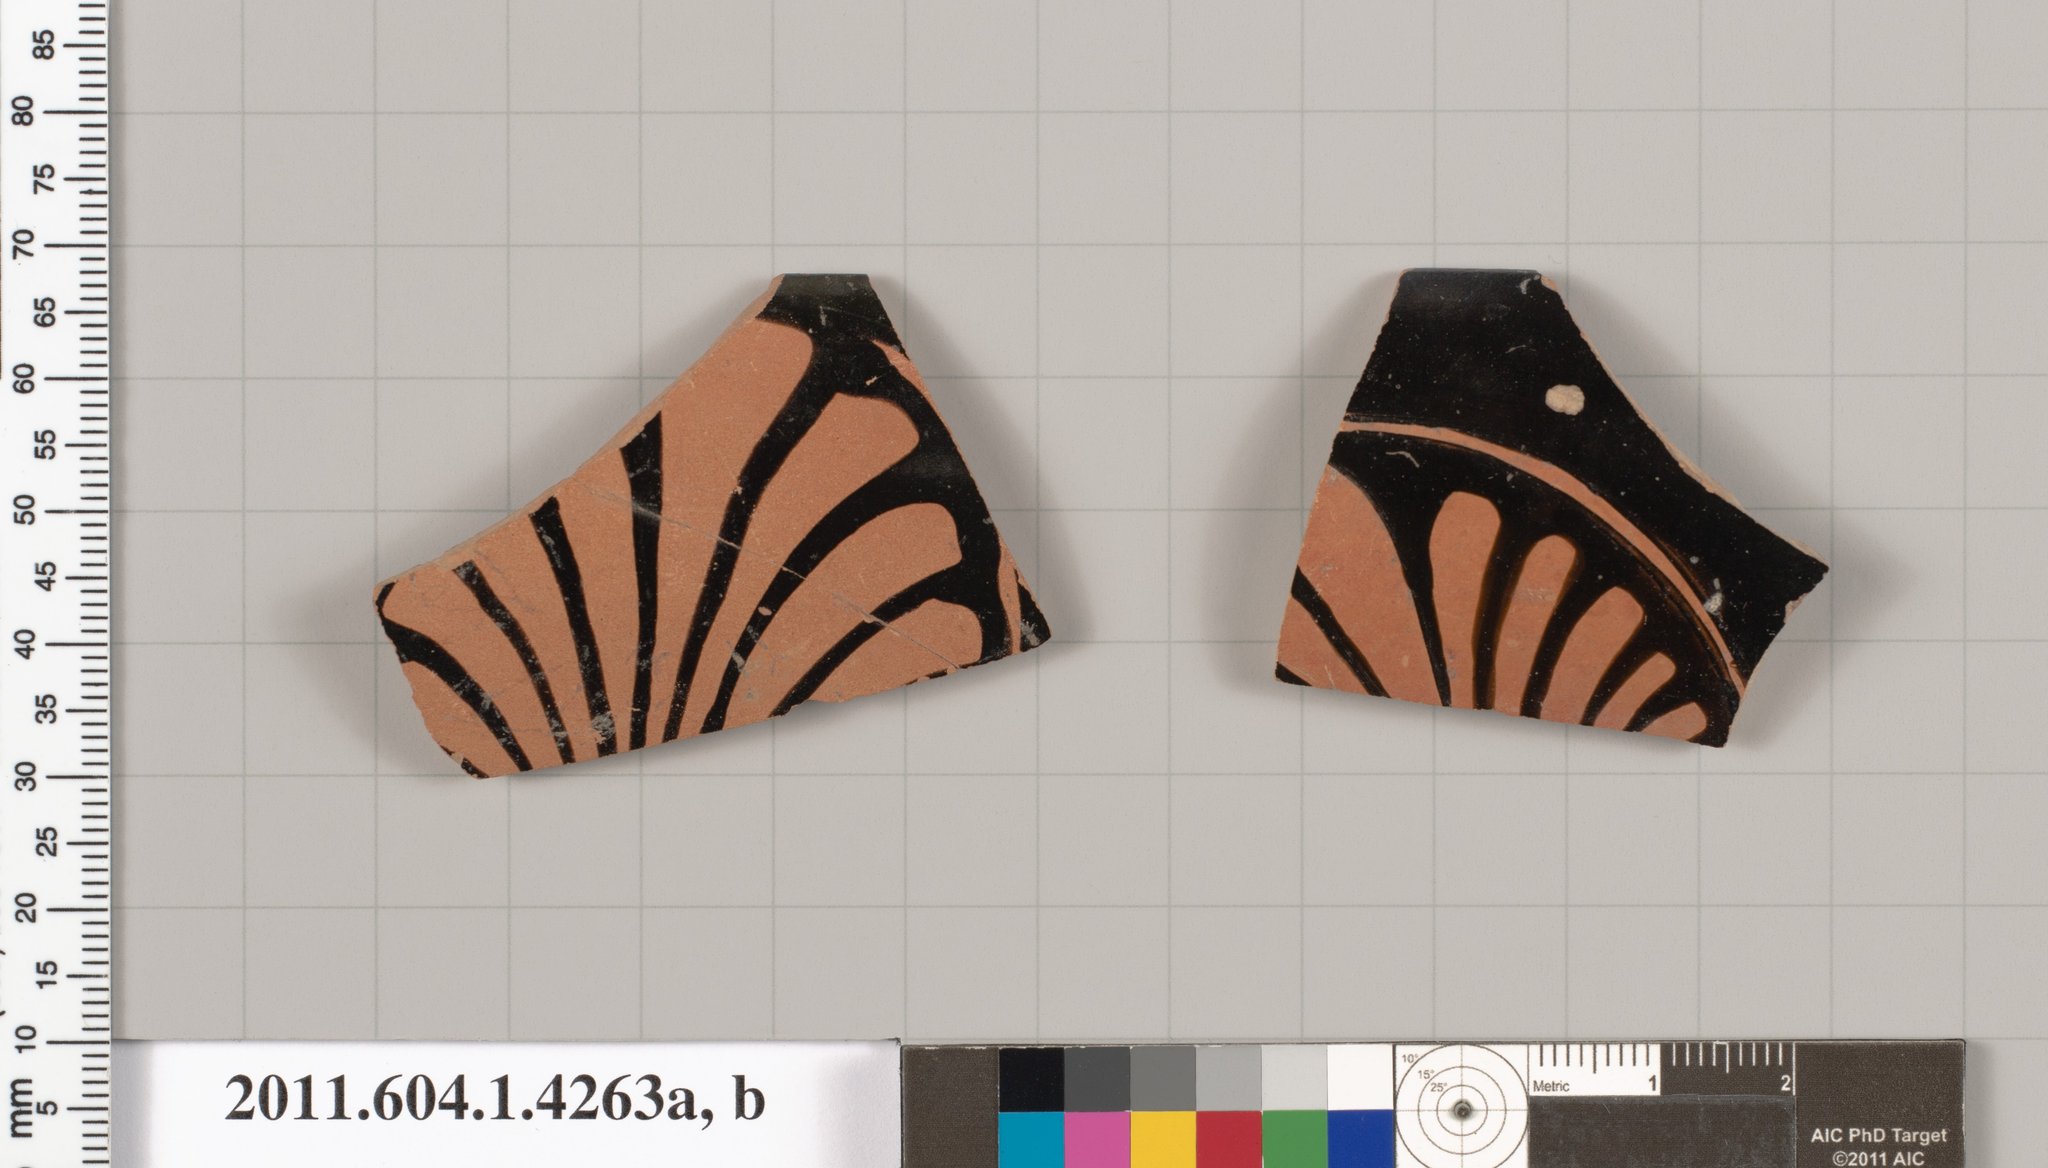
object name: kylix fragment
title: Terracotta rim fragments of kylikes (drinking cups)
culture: greek, attic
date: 500-451 BCE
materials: terracotta